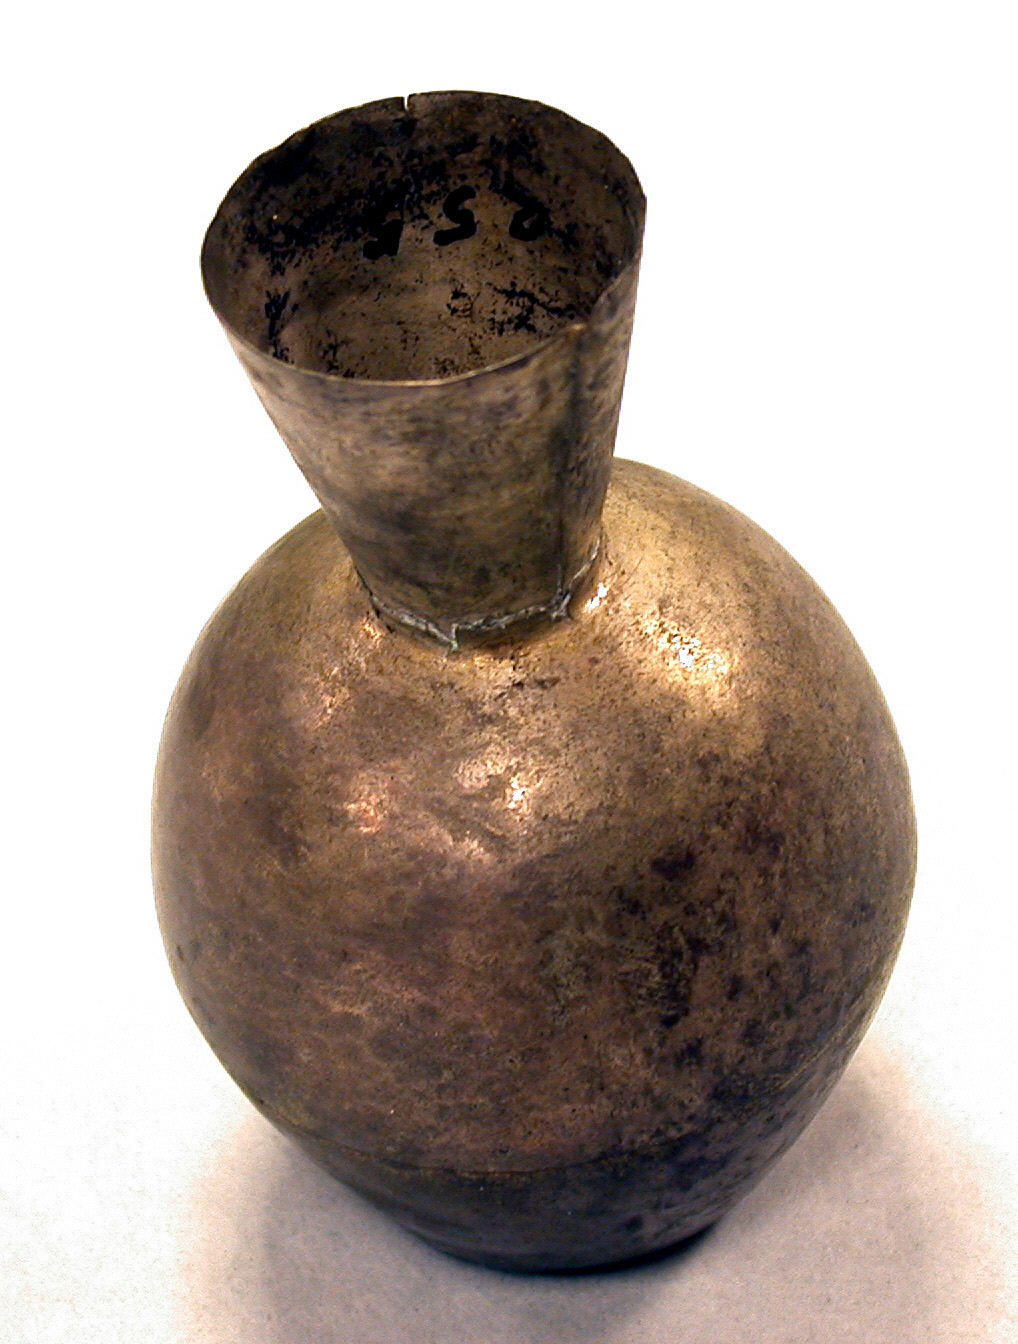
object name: bottle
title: Miniature Bottle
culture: chancay or chimú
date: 1001-1500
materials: gilt, silver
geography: peru